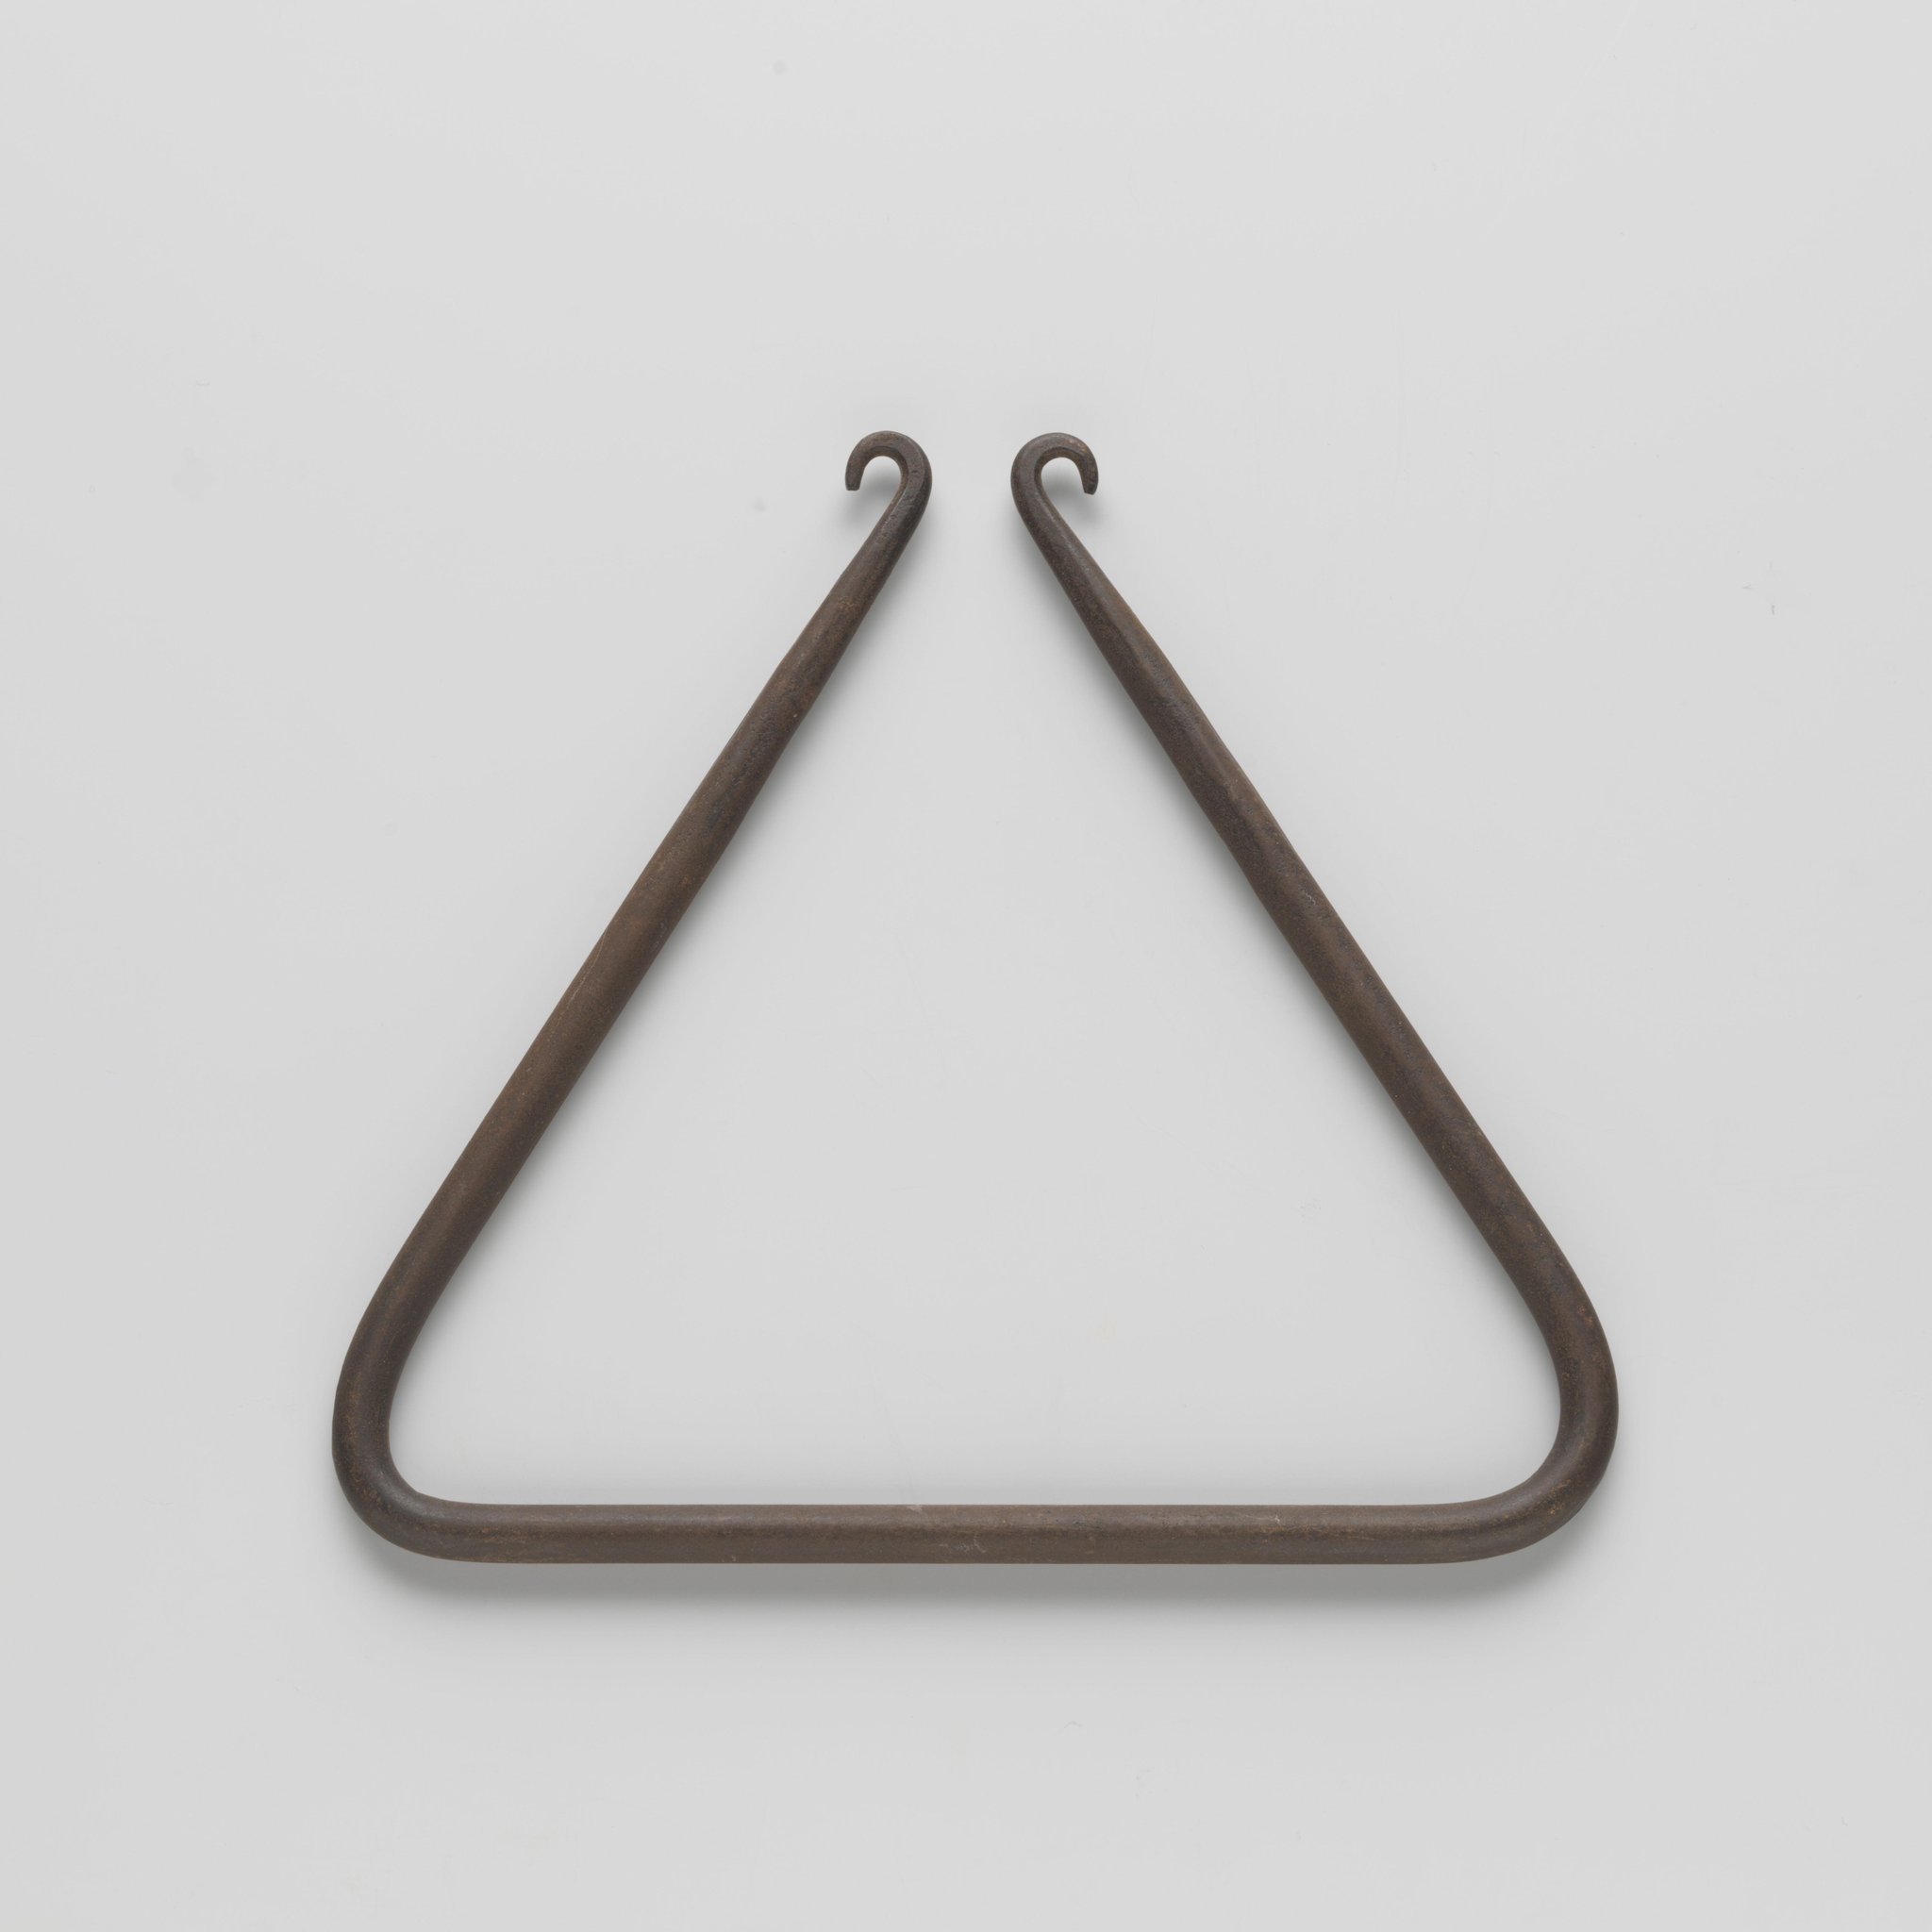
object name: percussion instrument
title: Triangle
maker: Anonymous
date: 1800-1899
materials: iron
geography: europe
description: 19e-eeuwse gesmede triangel, zonder verder toebehoren. In zeer goede conditie.